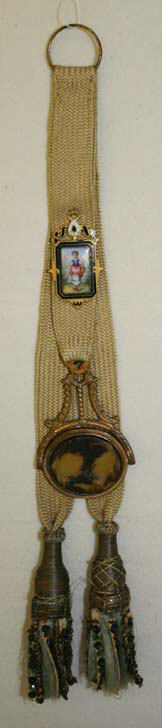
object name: fob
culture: german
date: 1767-1800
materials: metal, silk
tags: girls